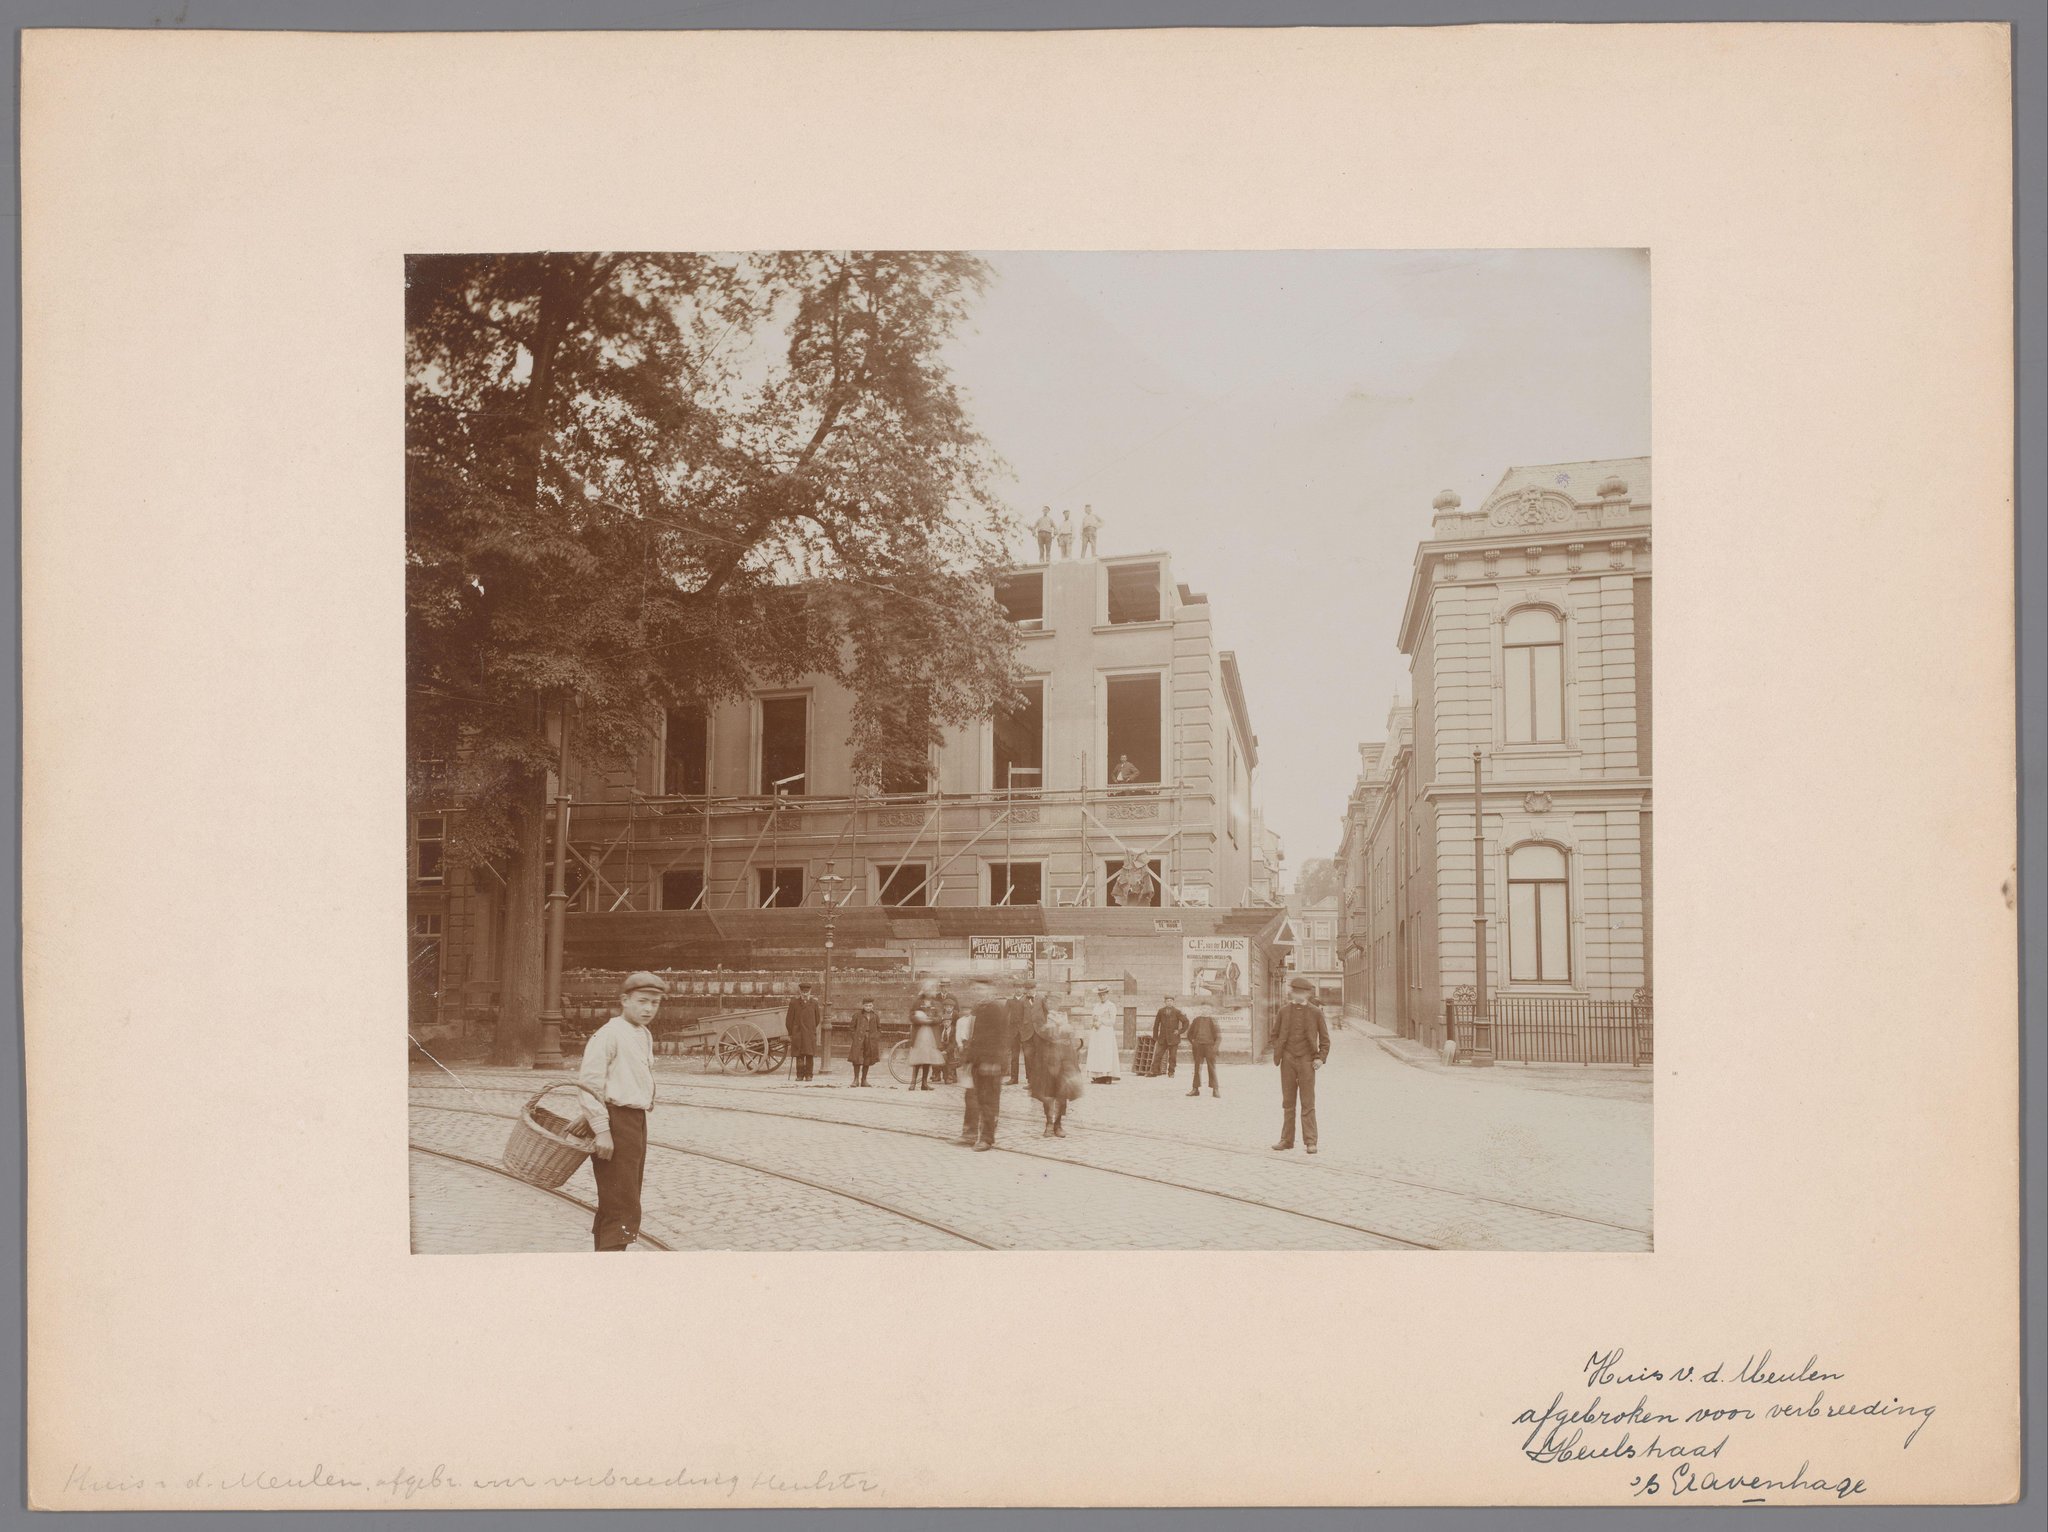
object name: photograph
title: Gezicht op het hoekhuis van de Heulstraat en de Kneuterdijk te Den Haag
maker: anoniem (monumentenzorg)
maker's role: fotograaf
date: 1890-1910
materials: cardboard, photographic support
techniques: collodion silver print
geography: kneuterdijk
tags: façade (of house or building), public road (+ city(-scape) with figures, staffage)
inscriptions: collector's mark: ‘R:MUS.’ Lugt 2228, annotation: ‘Huis v.d. Meulen, afgebr. voor verbreding Heulstr./ Huis v.d Meulen afgebroken voor verbreeding Heulstraat/ 's Gravenhage’, annotation: ‘'s Gravenhage (Z.H.)/ Afbraak huis v.d. Oudemeulen voor de verbreeding v.d Heulstraat’